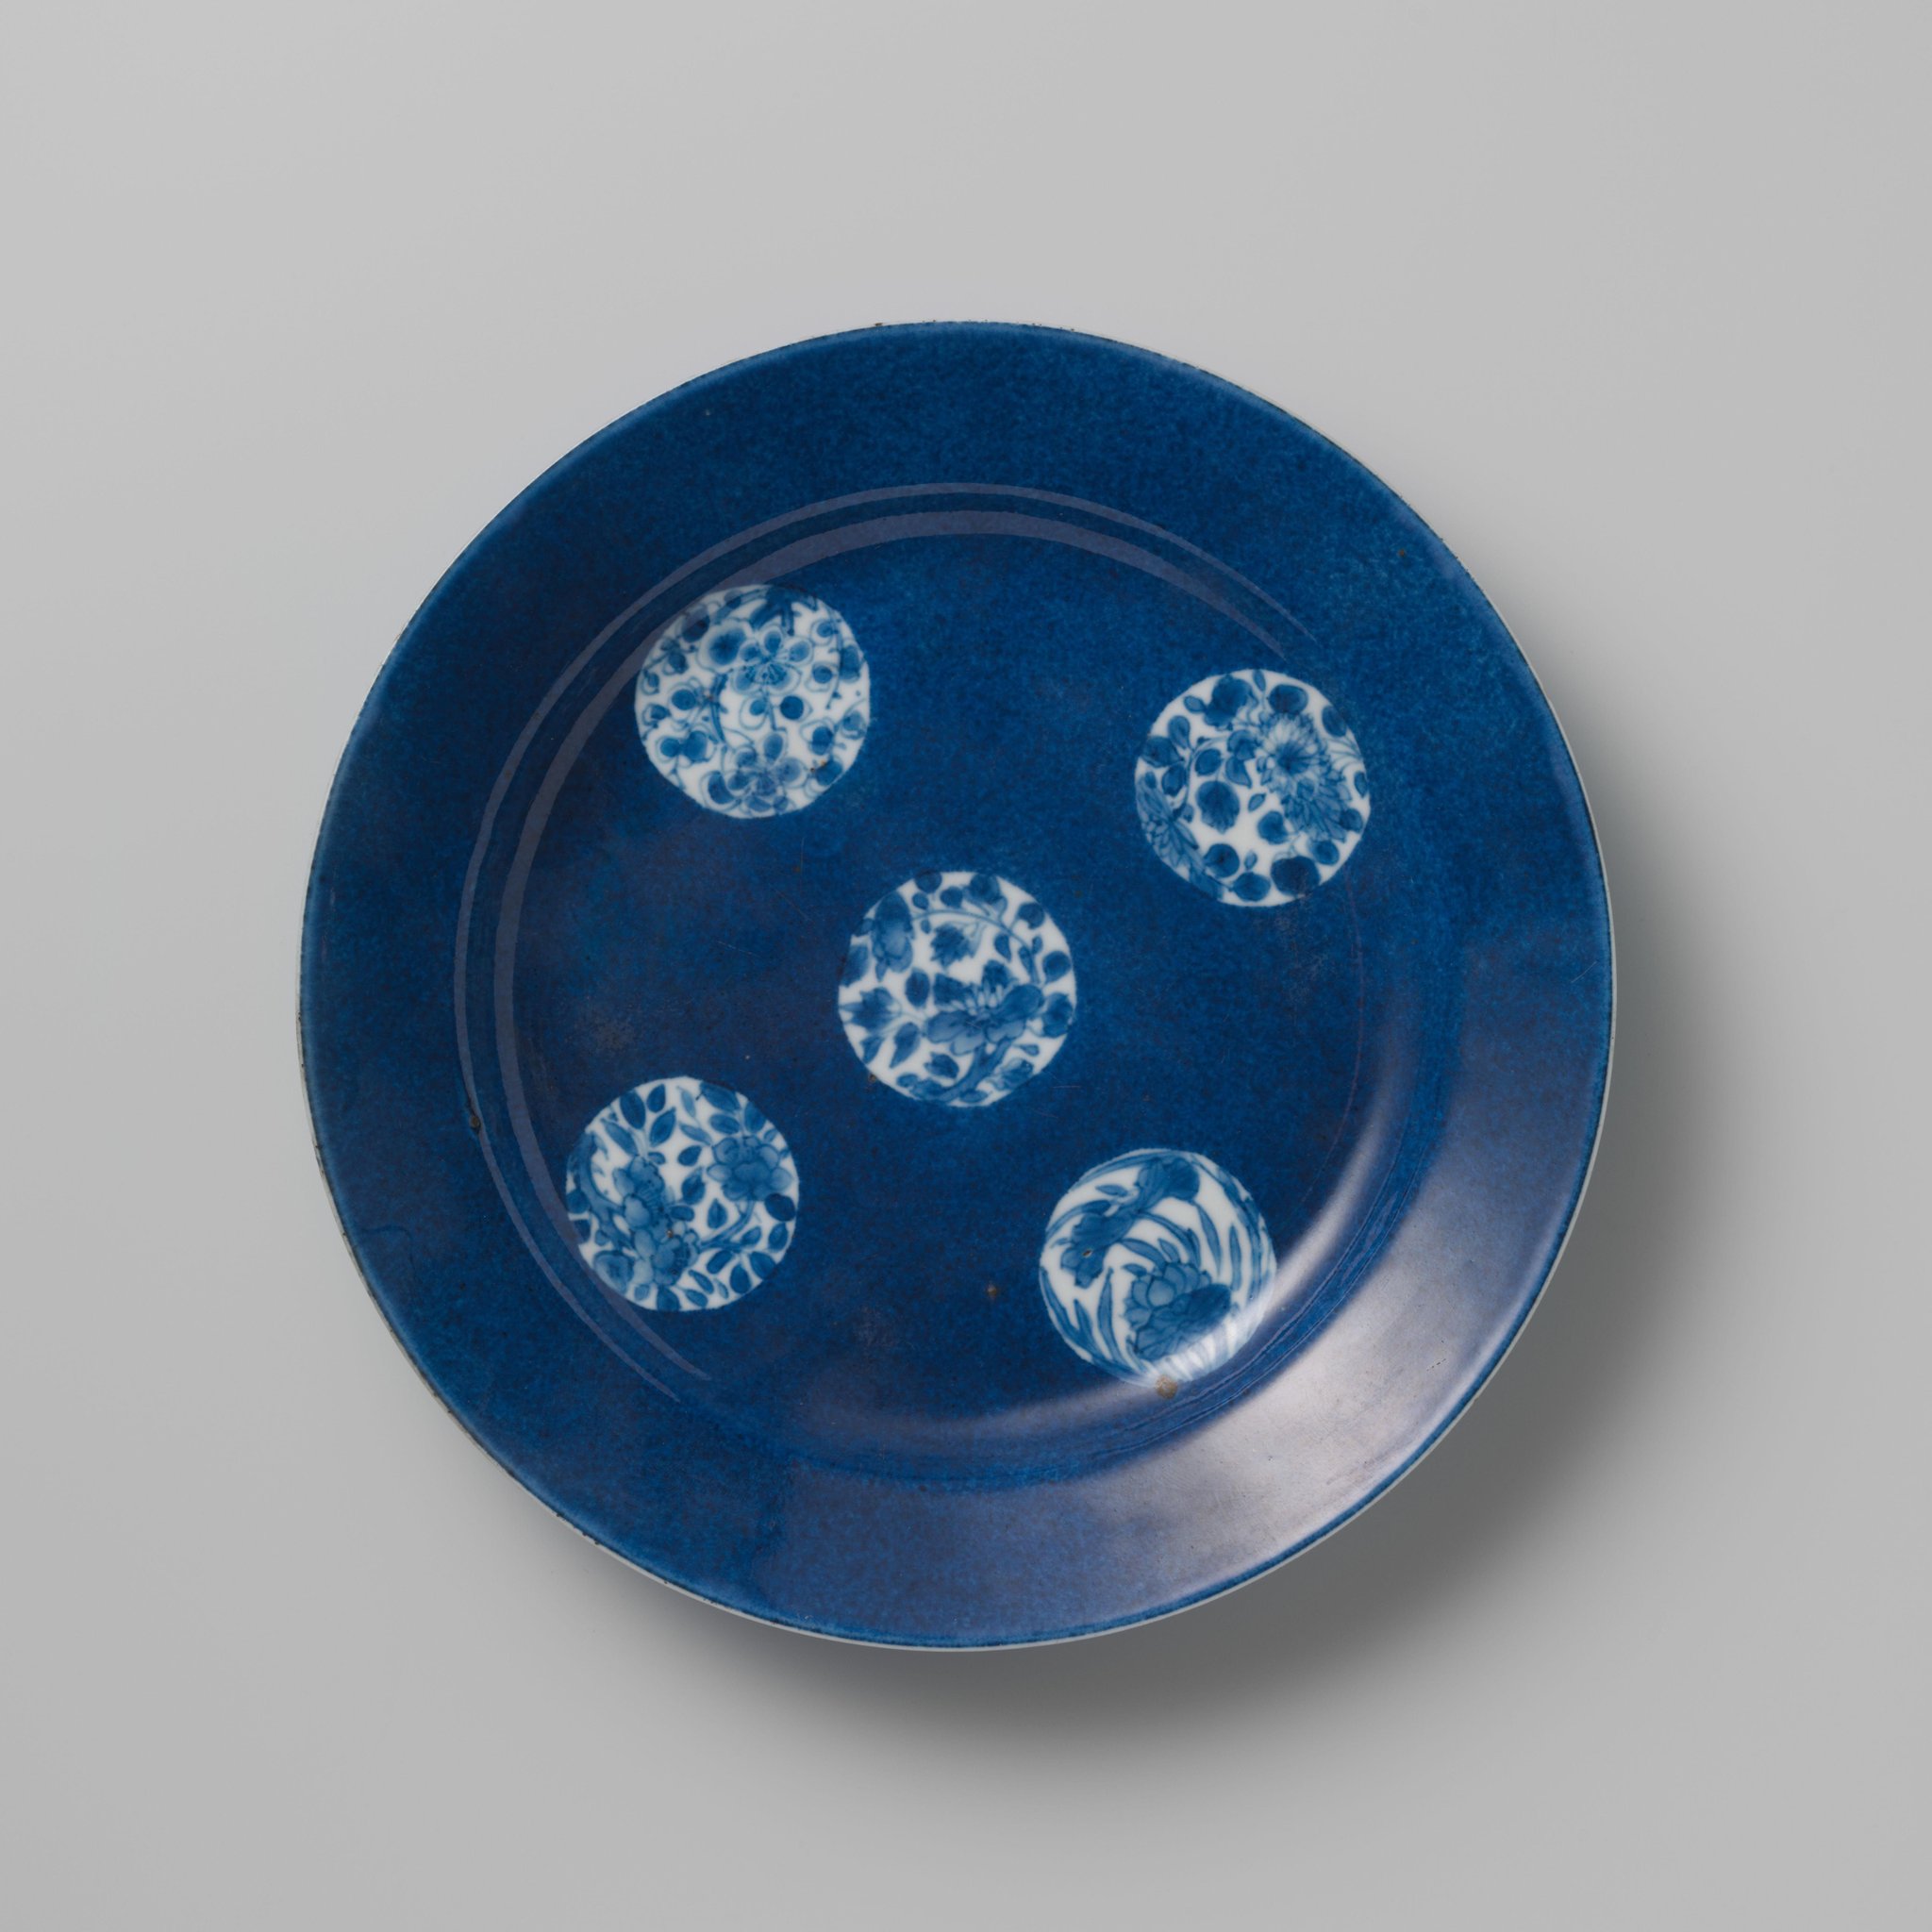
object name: plate dish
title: Plate with powder blue and five medallions with flower sprays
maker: Anonymous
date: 1700-1724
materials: cobalt, glaze, paint, porcelain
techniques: firing, turning, vitrification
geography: china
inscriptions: mark: ‘亞’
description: Bord van porselein met opstaande wand en schuine rand, beschilderd in onderglazuur blauw. De voorzijde is bedekt met bleu poudré (poederblauw) met hierin uitgespaard vijf medaillons gevuld met bloemtakken; de achterzijde van de wand is volledig bedekt met poederblauw. Gemerkt op de onderzijde met een van de Twaalf Ornamenten, het Fú symbool, in een dubbele cirkel. Twee chips in de rand. Bleu poudré met blauw-wit.